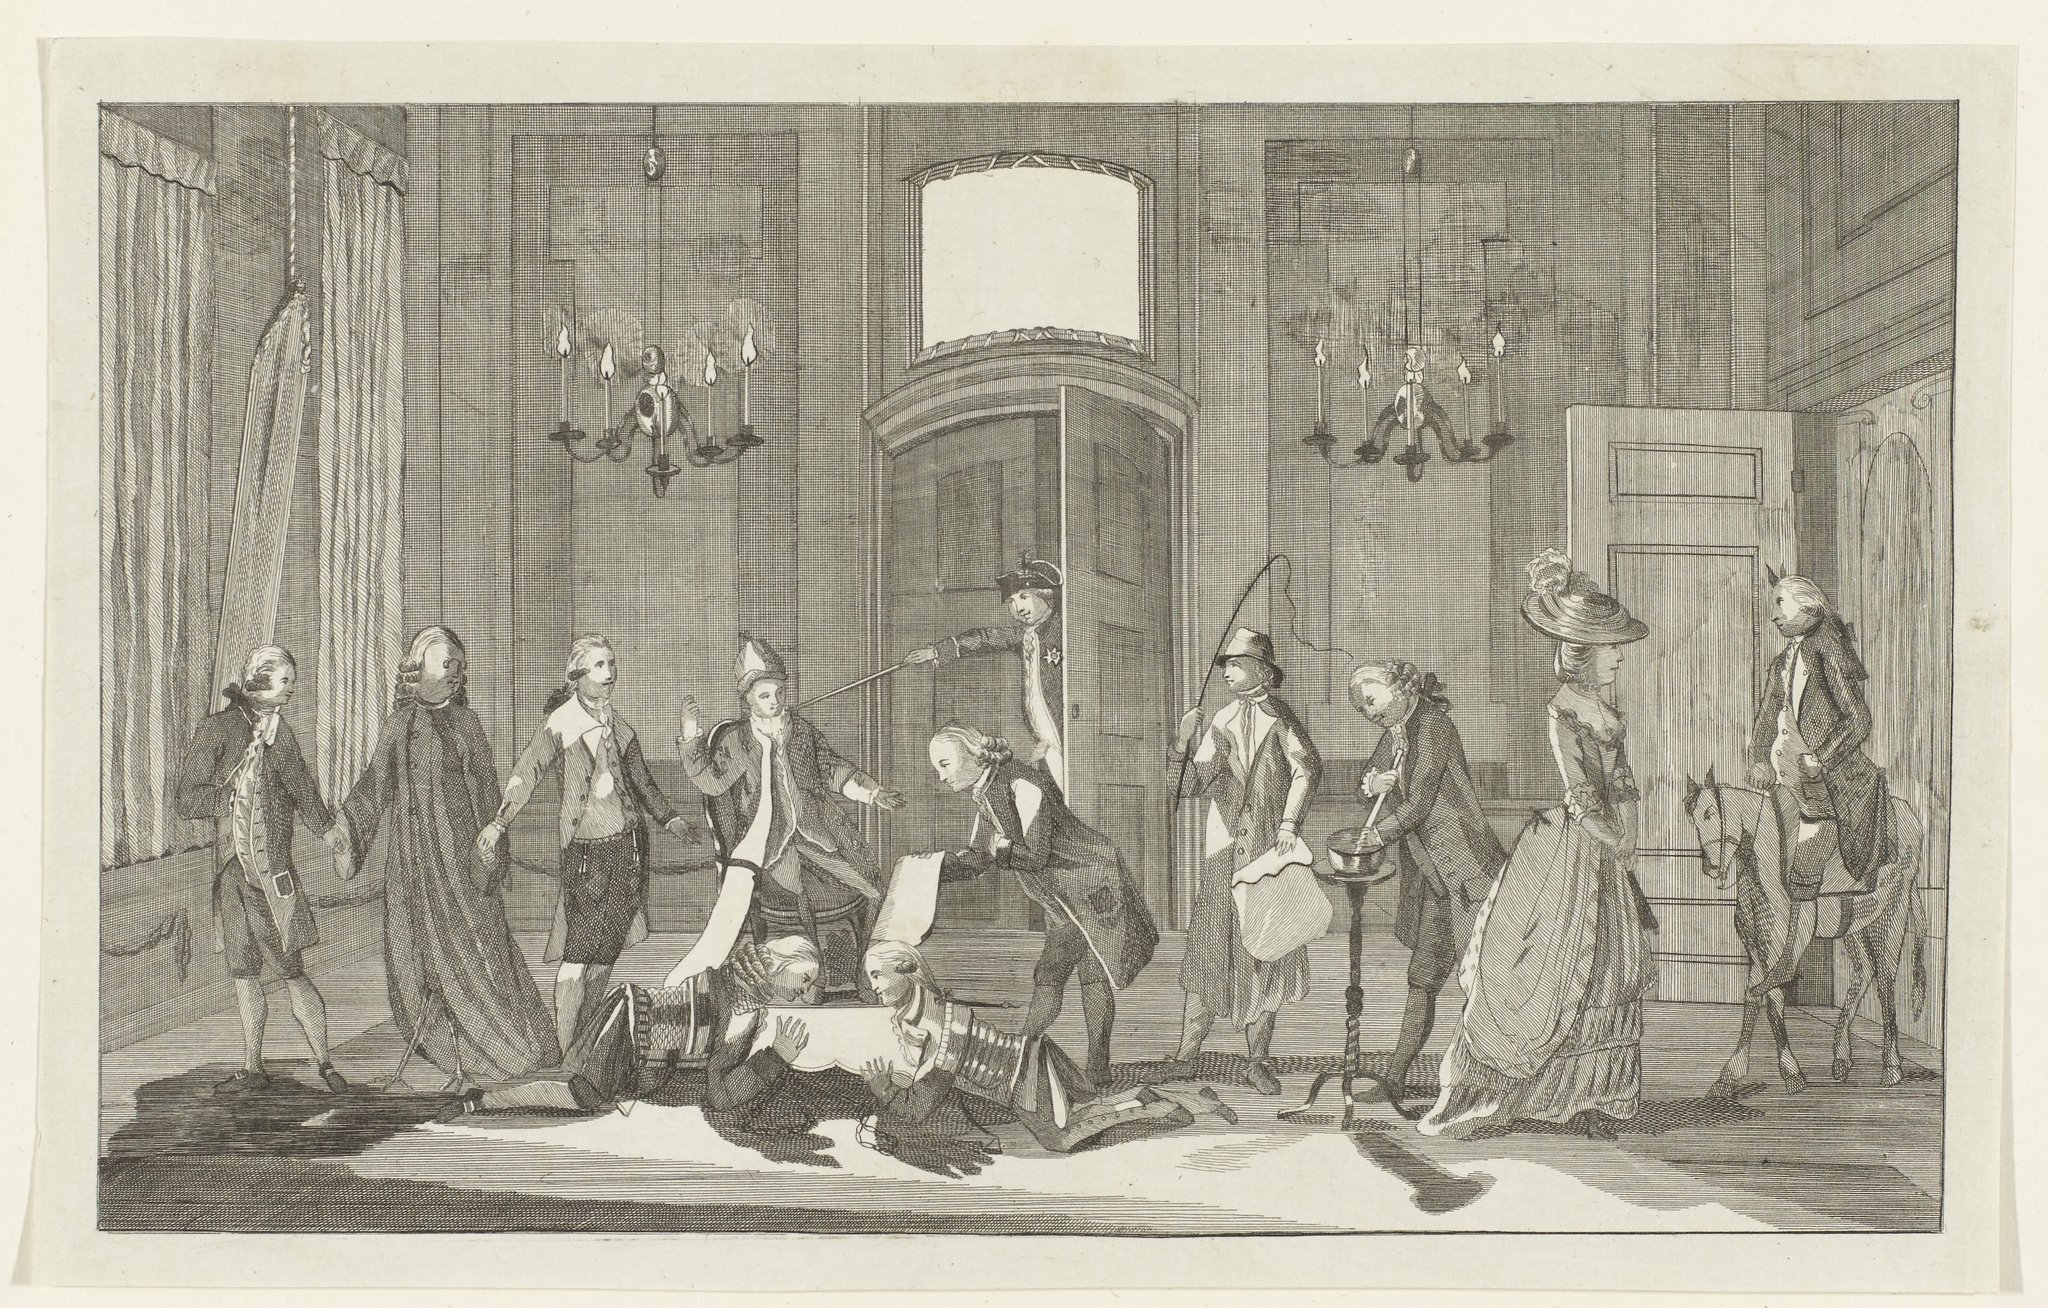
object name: cartoon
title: Spotprent op de prins en zijn aanhang, 1782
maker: Anonymous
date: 1782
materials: paper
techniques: etching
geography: northern netherlands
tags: william v (prince of orange), leiden, the hague, print maker, draughtsman, petrus camper, political caricatures and satires, patriots (1780-1795)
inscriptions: collector's mark: Lugt 2228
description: Spotprent op prins Willem V van Oranje en de Friese tak. Kamer waarin de prins binnenkomt, centraal staat P. Wierdsma met 'Plan om Friesland onder 't juk te brengen' en de twee heren Jr. W. van Hambroick Protector der Hoerenwaarden en Col. Plettenberg op de grond met zadels op hun vrouwenrug met 'Rechten en Vrijheeden der Frieschen Volks'. Links grietman Idema, professor Petrus Camper, A. Lyklama a Nieholt Vrijheer van Sodom, Jr. Ch. Bigot. Rechts Grietman v.d. Haar, R. Acronius, Messalina Schepper Geb: Scheltinga en Grietman Schepper de Hoorndrager rijdend op een ezel. In deze staat nog vóór alle namen en opschriften en de gefingeerde opdracht van 1 oktober 1782 en gefingeerde namen van vervaardigers. De voorstelling van de prent wordt uitgelegd in een "beknopte Verklaaring" en in een pamflet getiteld "De Friesche Volk-stem".